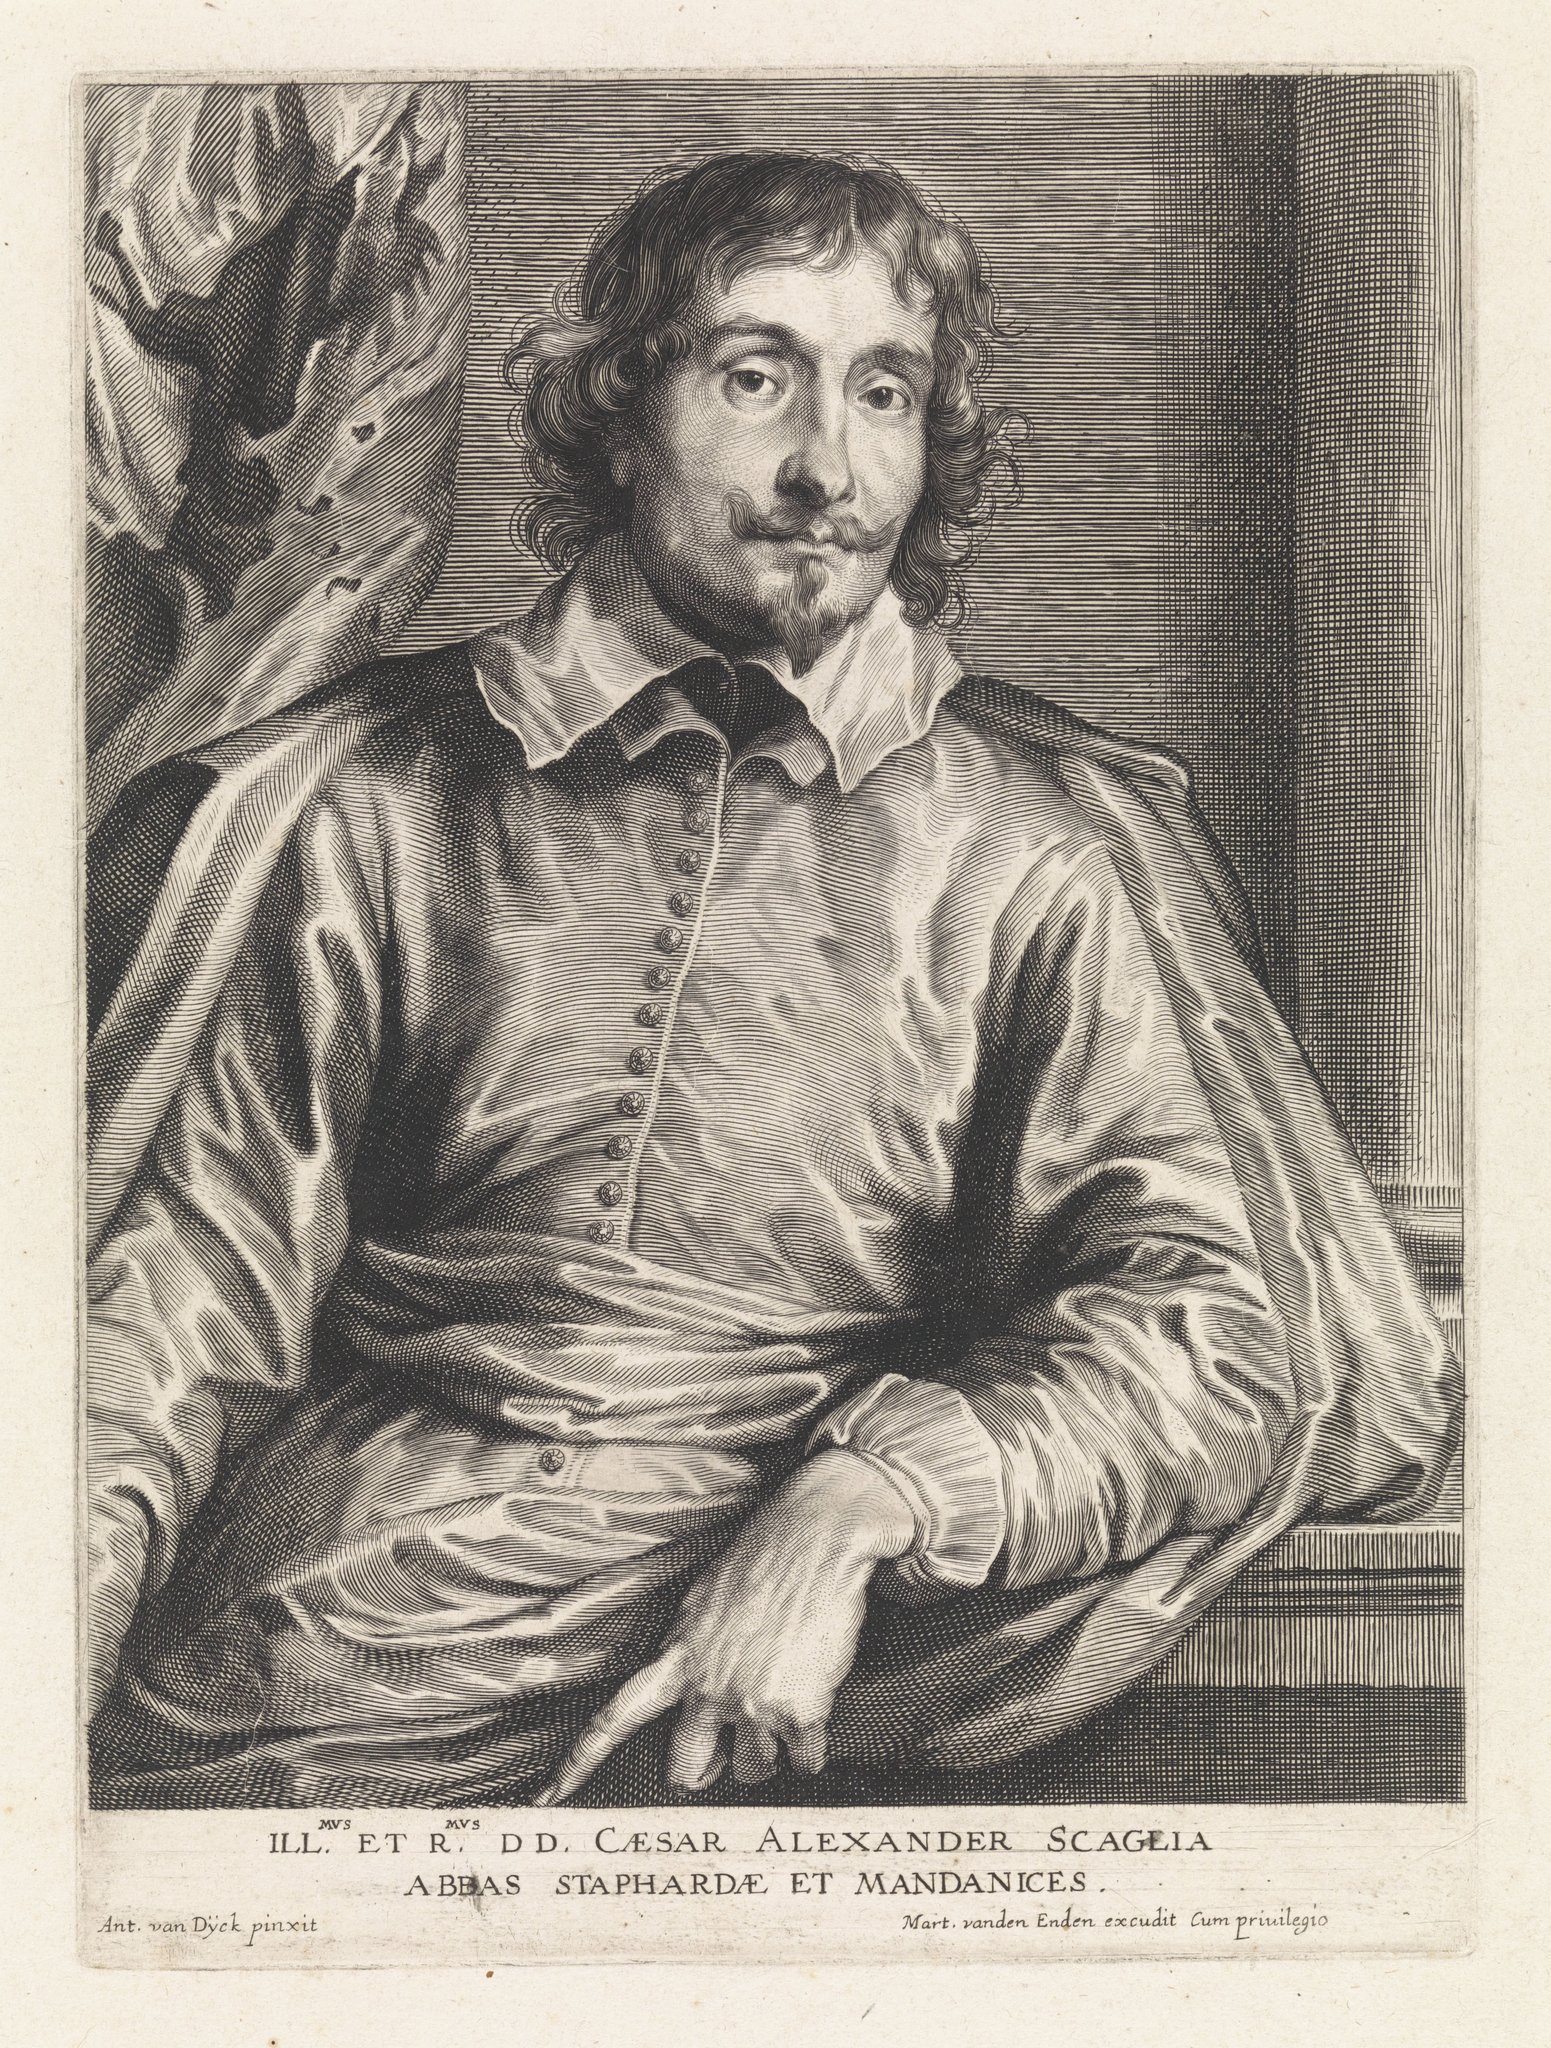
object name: print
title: Portret van Cesare Alessandro Scaglia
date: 1616-1657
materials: paper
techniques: engraving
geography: antwerp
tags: diplomaat, cesare alessandro scaglia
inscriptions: collector's mark: Lugt 240